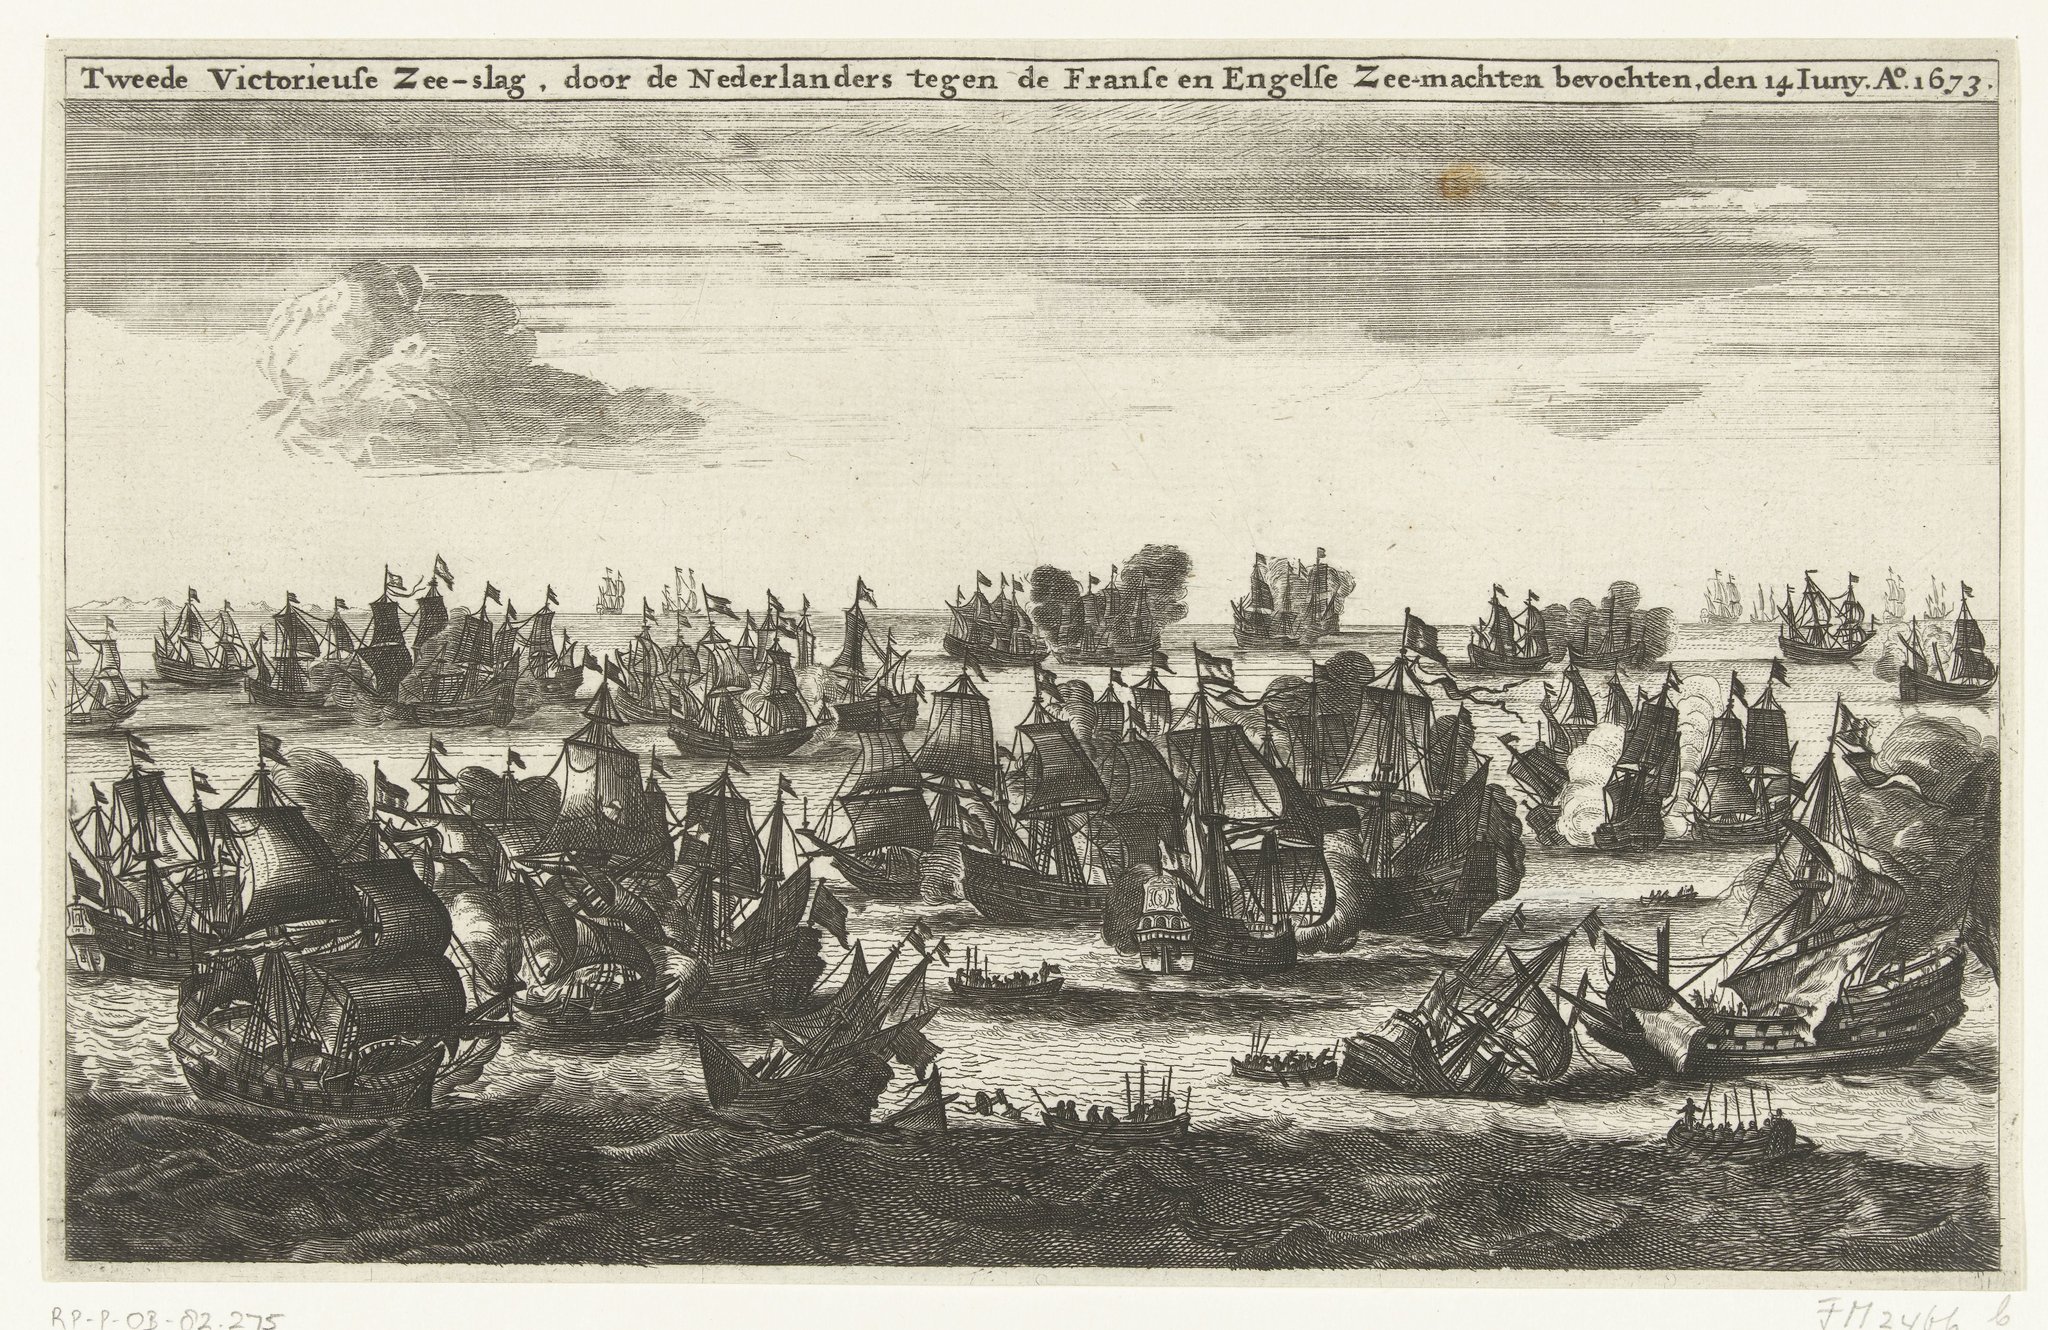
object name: history print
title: Tweede Victorieuse Zee-slag, door de Nederlanders tegen de Franse en Engelse Zee-machten bevochten, den 14 Juny Ao. 1673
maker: Anonymous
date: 1674-1676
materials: paper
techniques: etching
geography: northern netherlands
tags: prague, london, prinz ruprecht, flushing, michiel adriaenszoon de ruyter, cornelis tromp, battle (+ naval force), second battle of schooneveld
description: De zeeslag voor de Zeeuwse kust op de vlakte van Schoonevelt op 14 juni 1673 tussen de vloot van de Republiek onder Michiel Adriaenszoon de Ruyter en de gecombineerde Engels-Franse vloot onder Prins Rupert en graaf Jean d'Estrées.